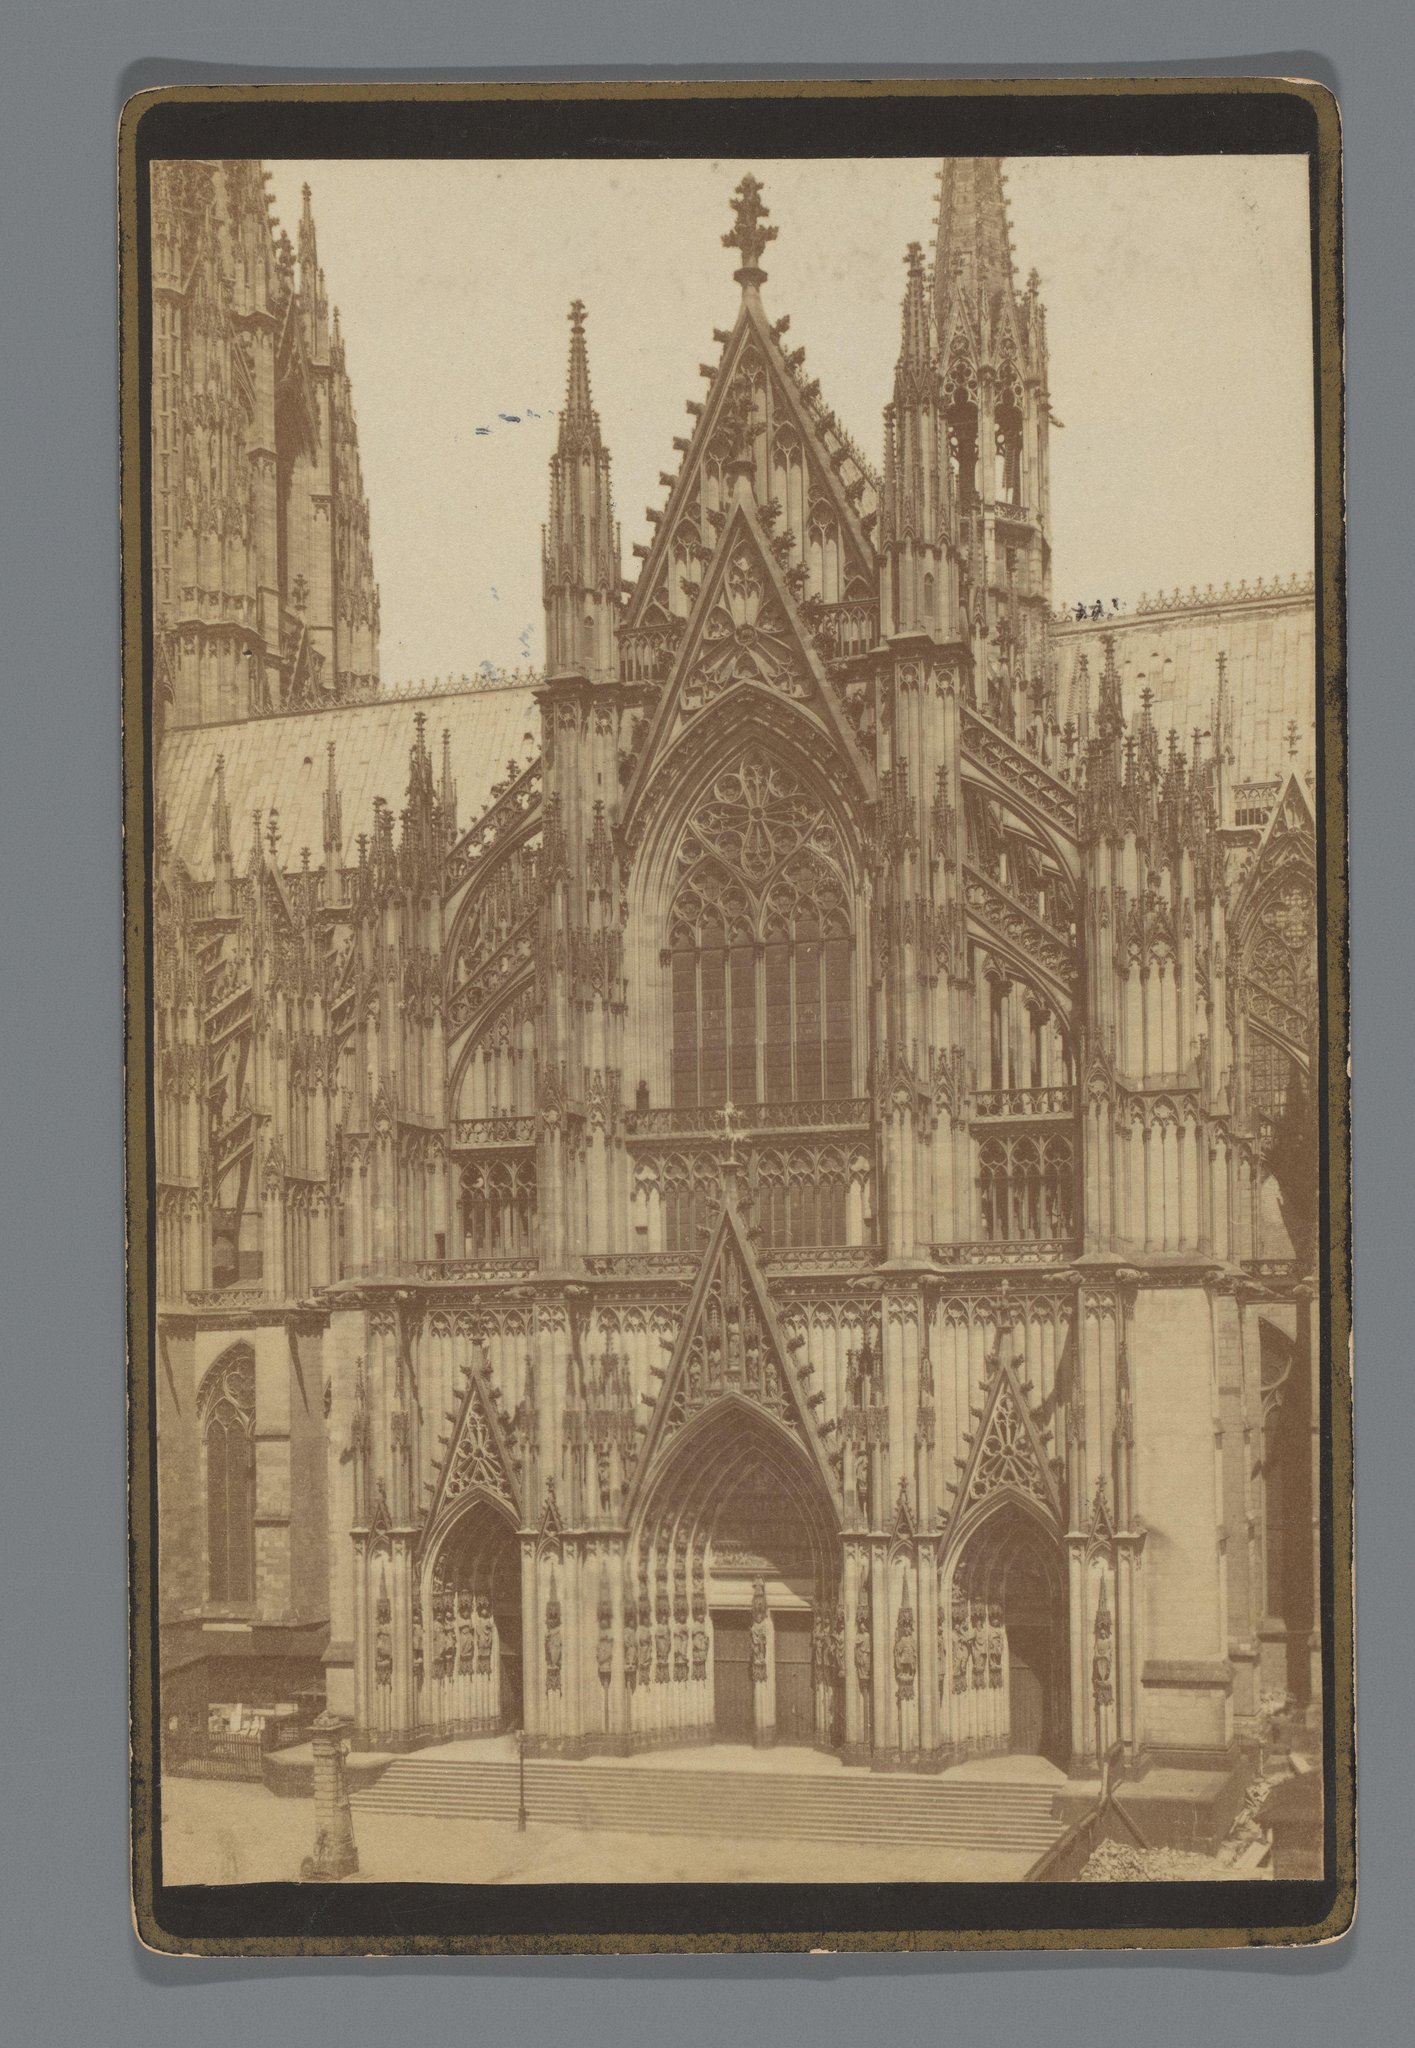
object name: photograph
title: Köln. Domkloster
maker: Anonymous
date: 1850-1880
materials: photographic support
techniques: albumen print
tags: dom van keulen